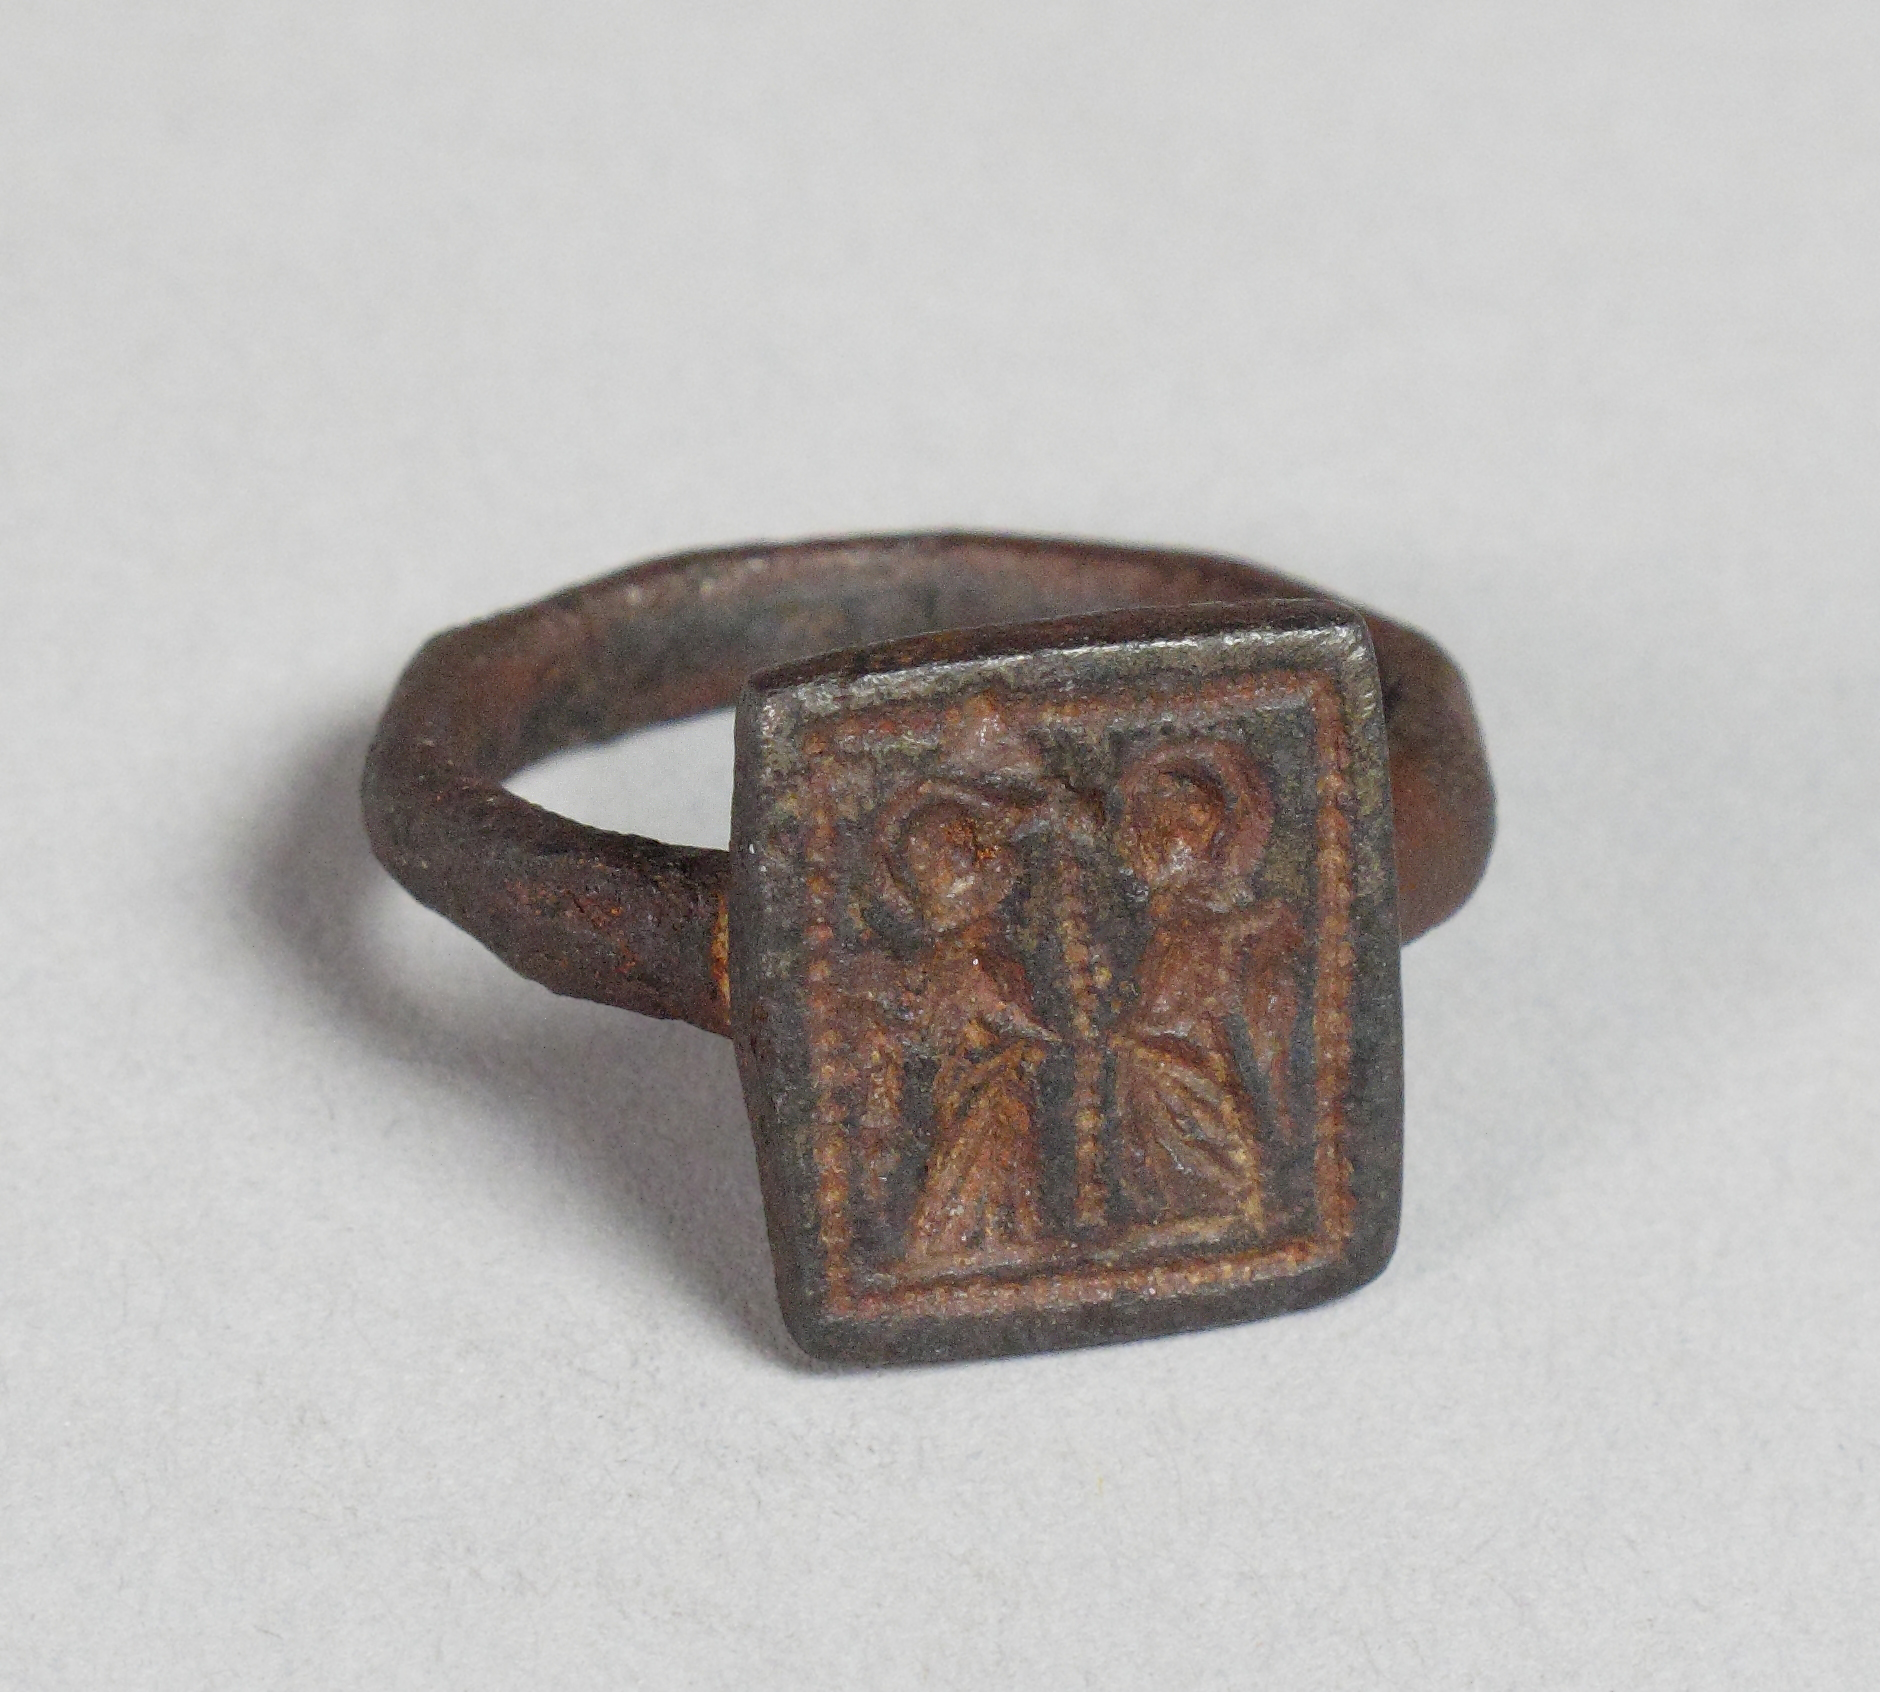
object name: ring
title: Signet Ring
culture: european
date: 1101-1300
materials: iron